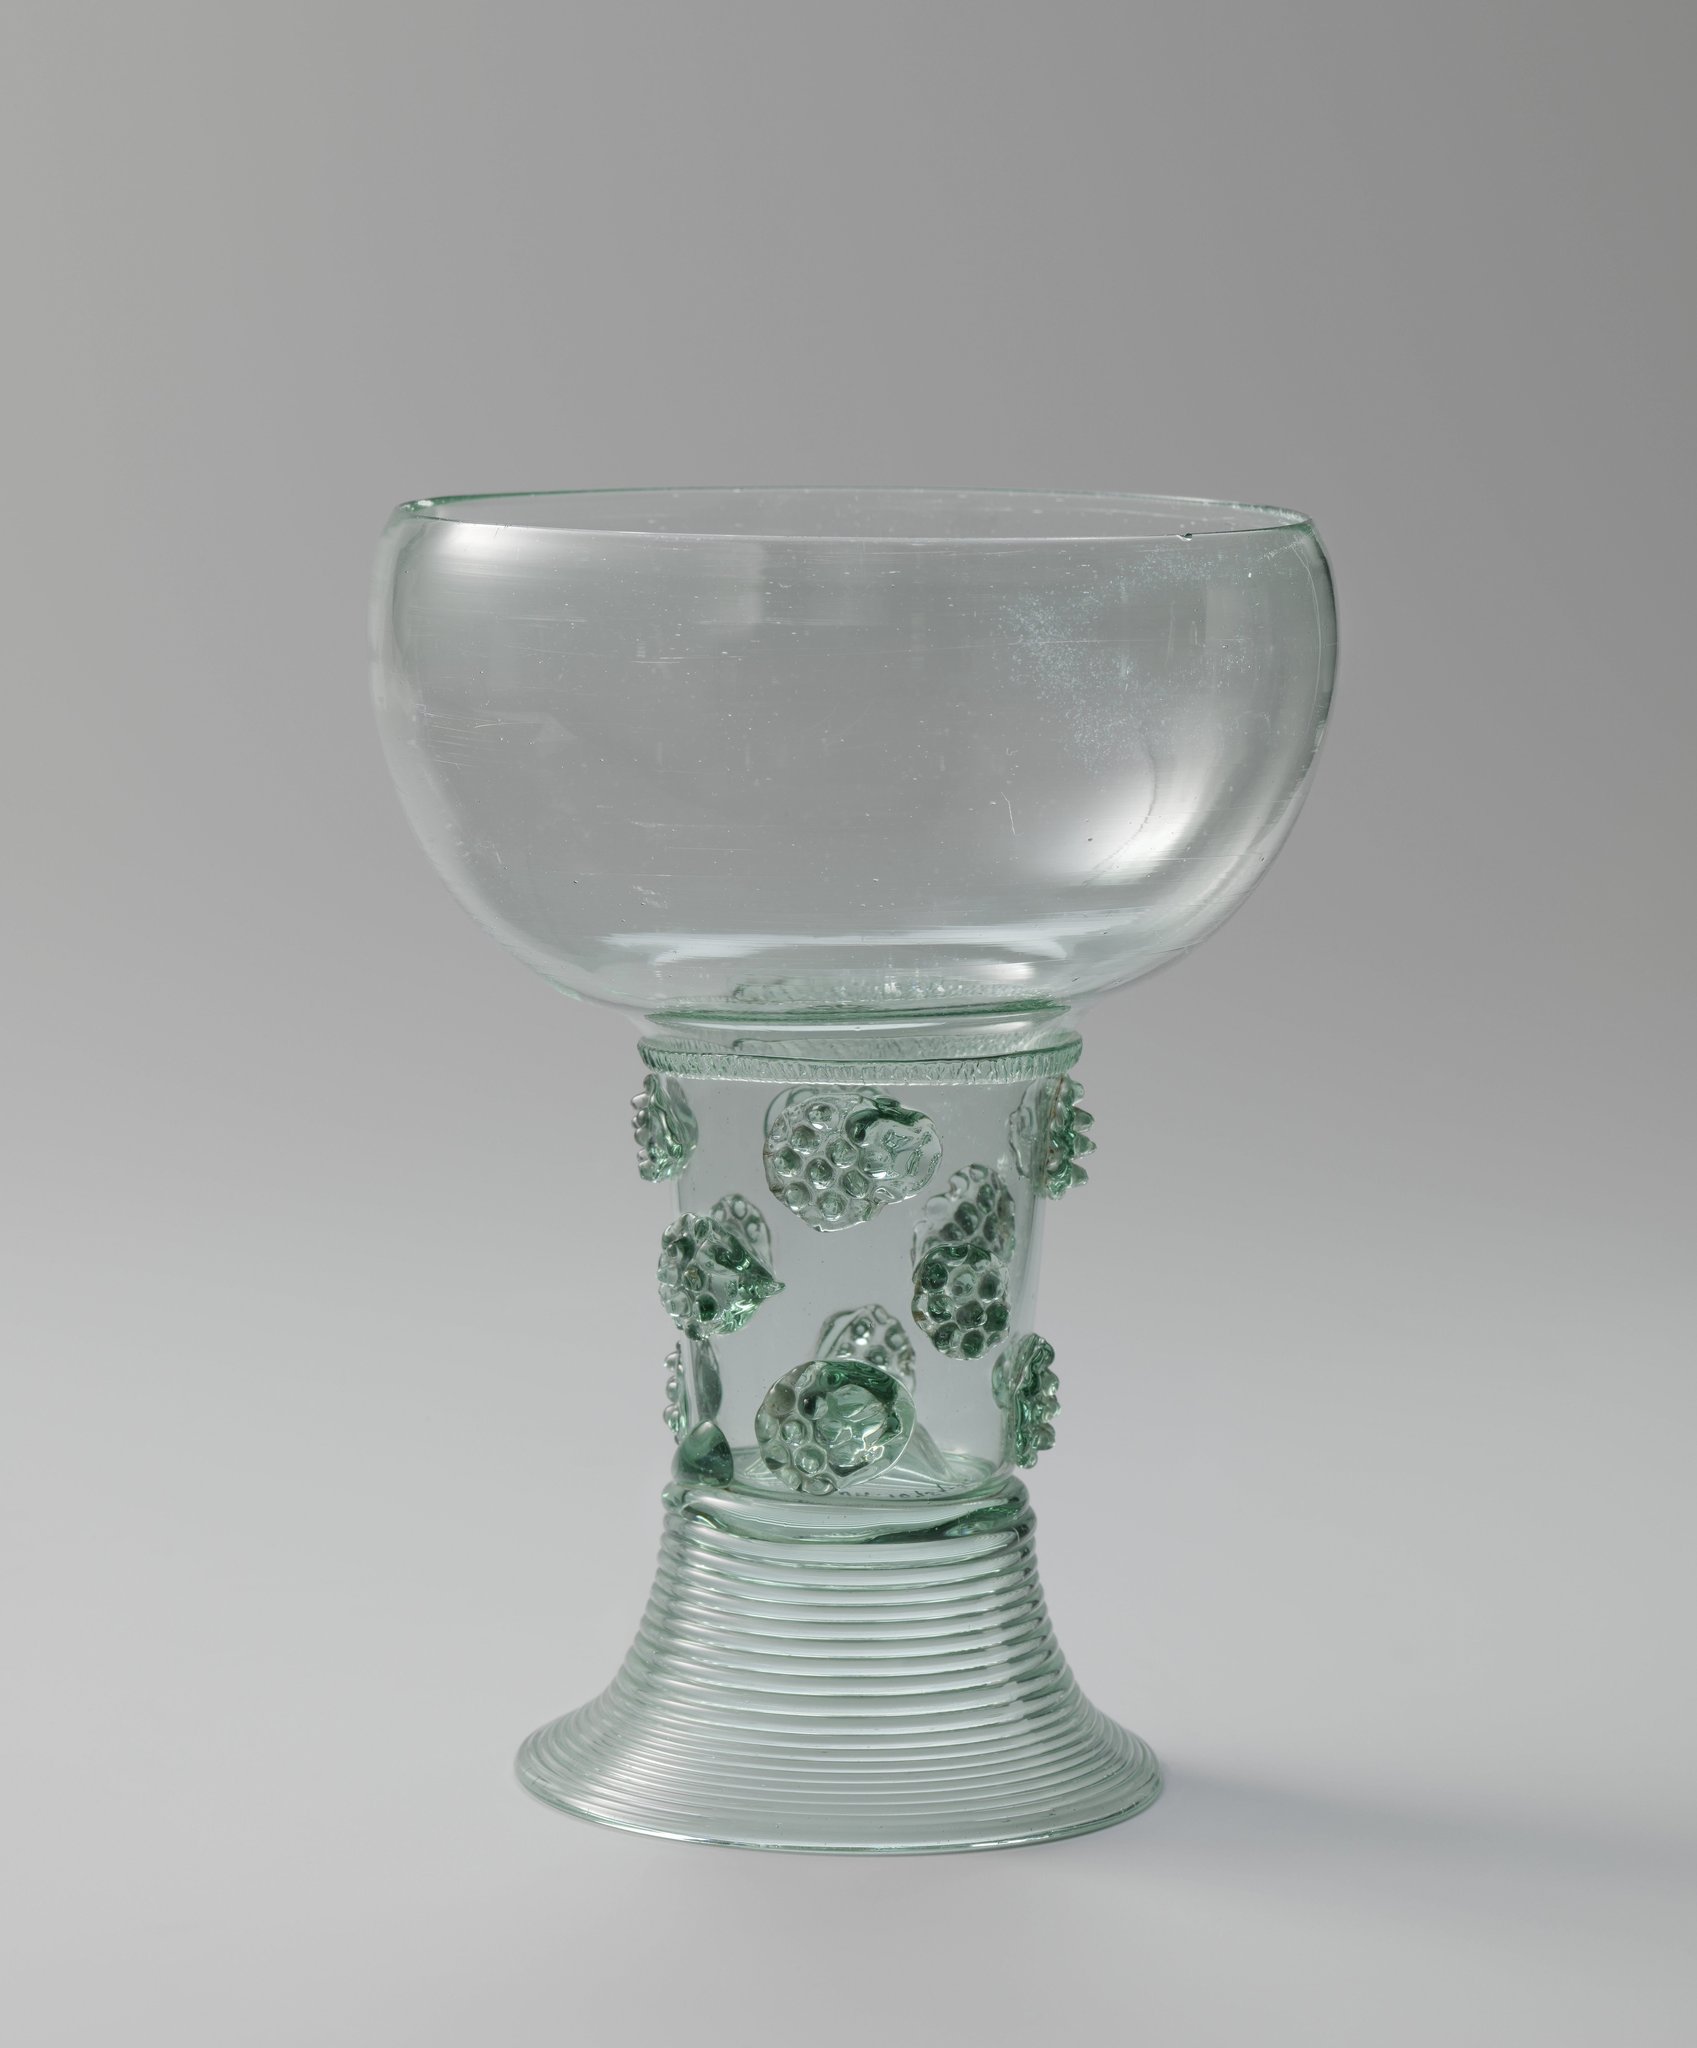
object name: roemer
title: Roemer with three rows of raspberry prunts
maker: Anonymous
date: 1675-1700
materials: glass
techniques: glassblowing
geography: germany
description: The Netherlands or Germany, c. 1675–1700 glass